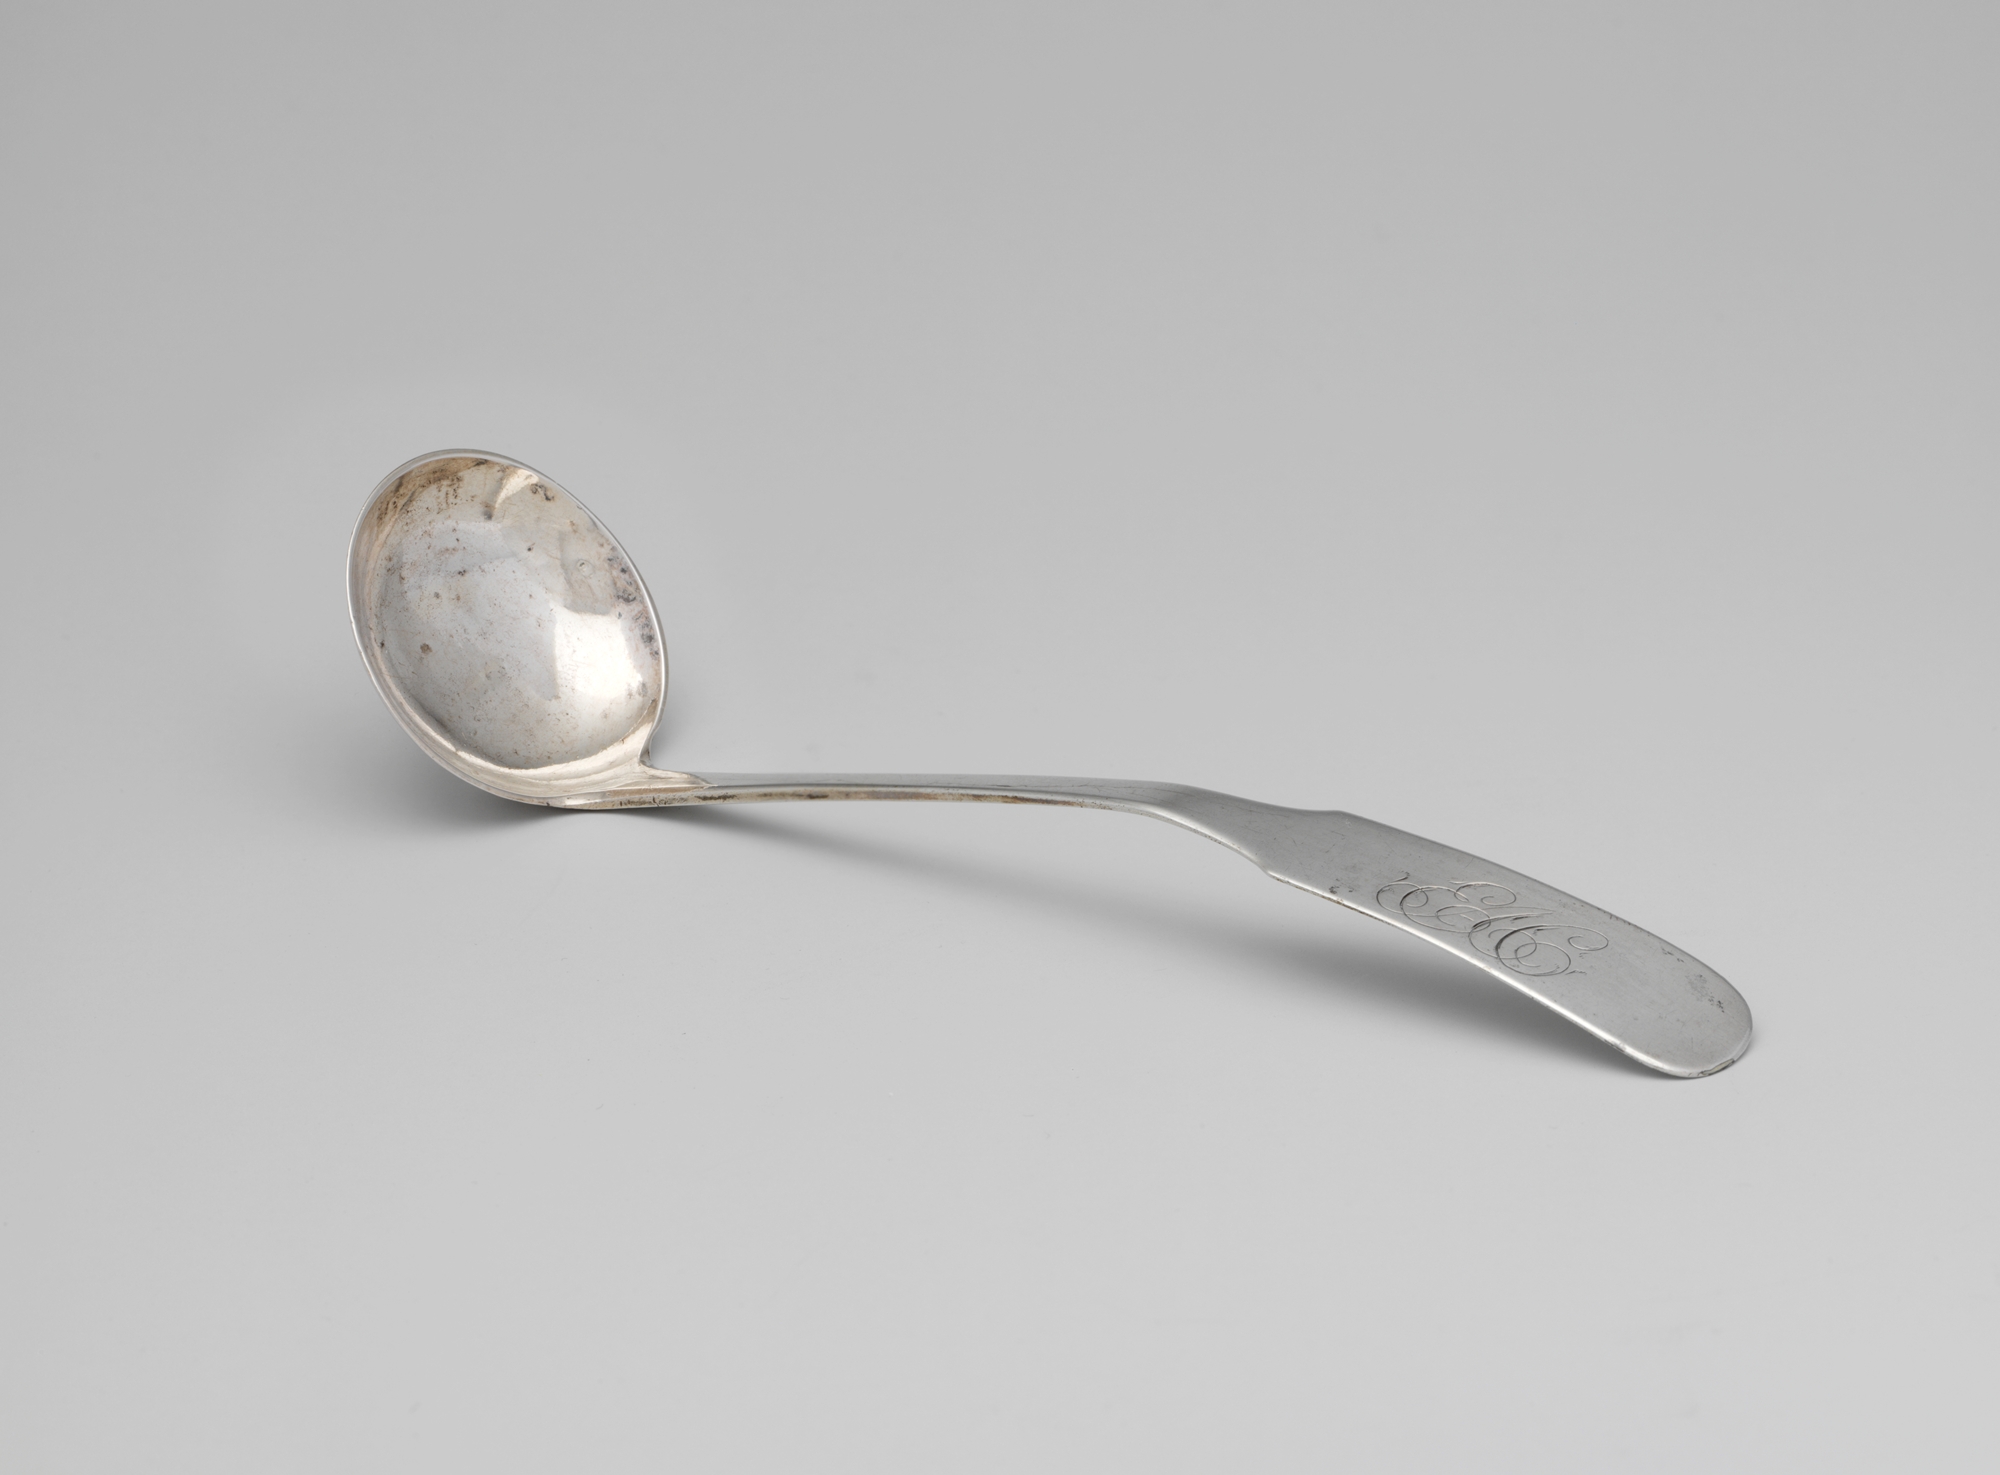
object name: ladle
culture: american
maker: s. yates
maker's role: maker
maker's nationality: american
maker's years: 1807-1825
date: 1810-1825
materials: silver